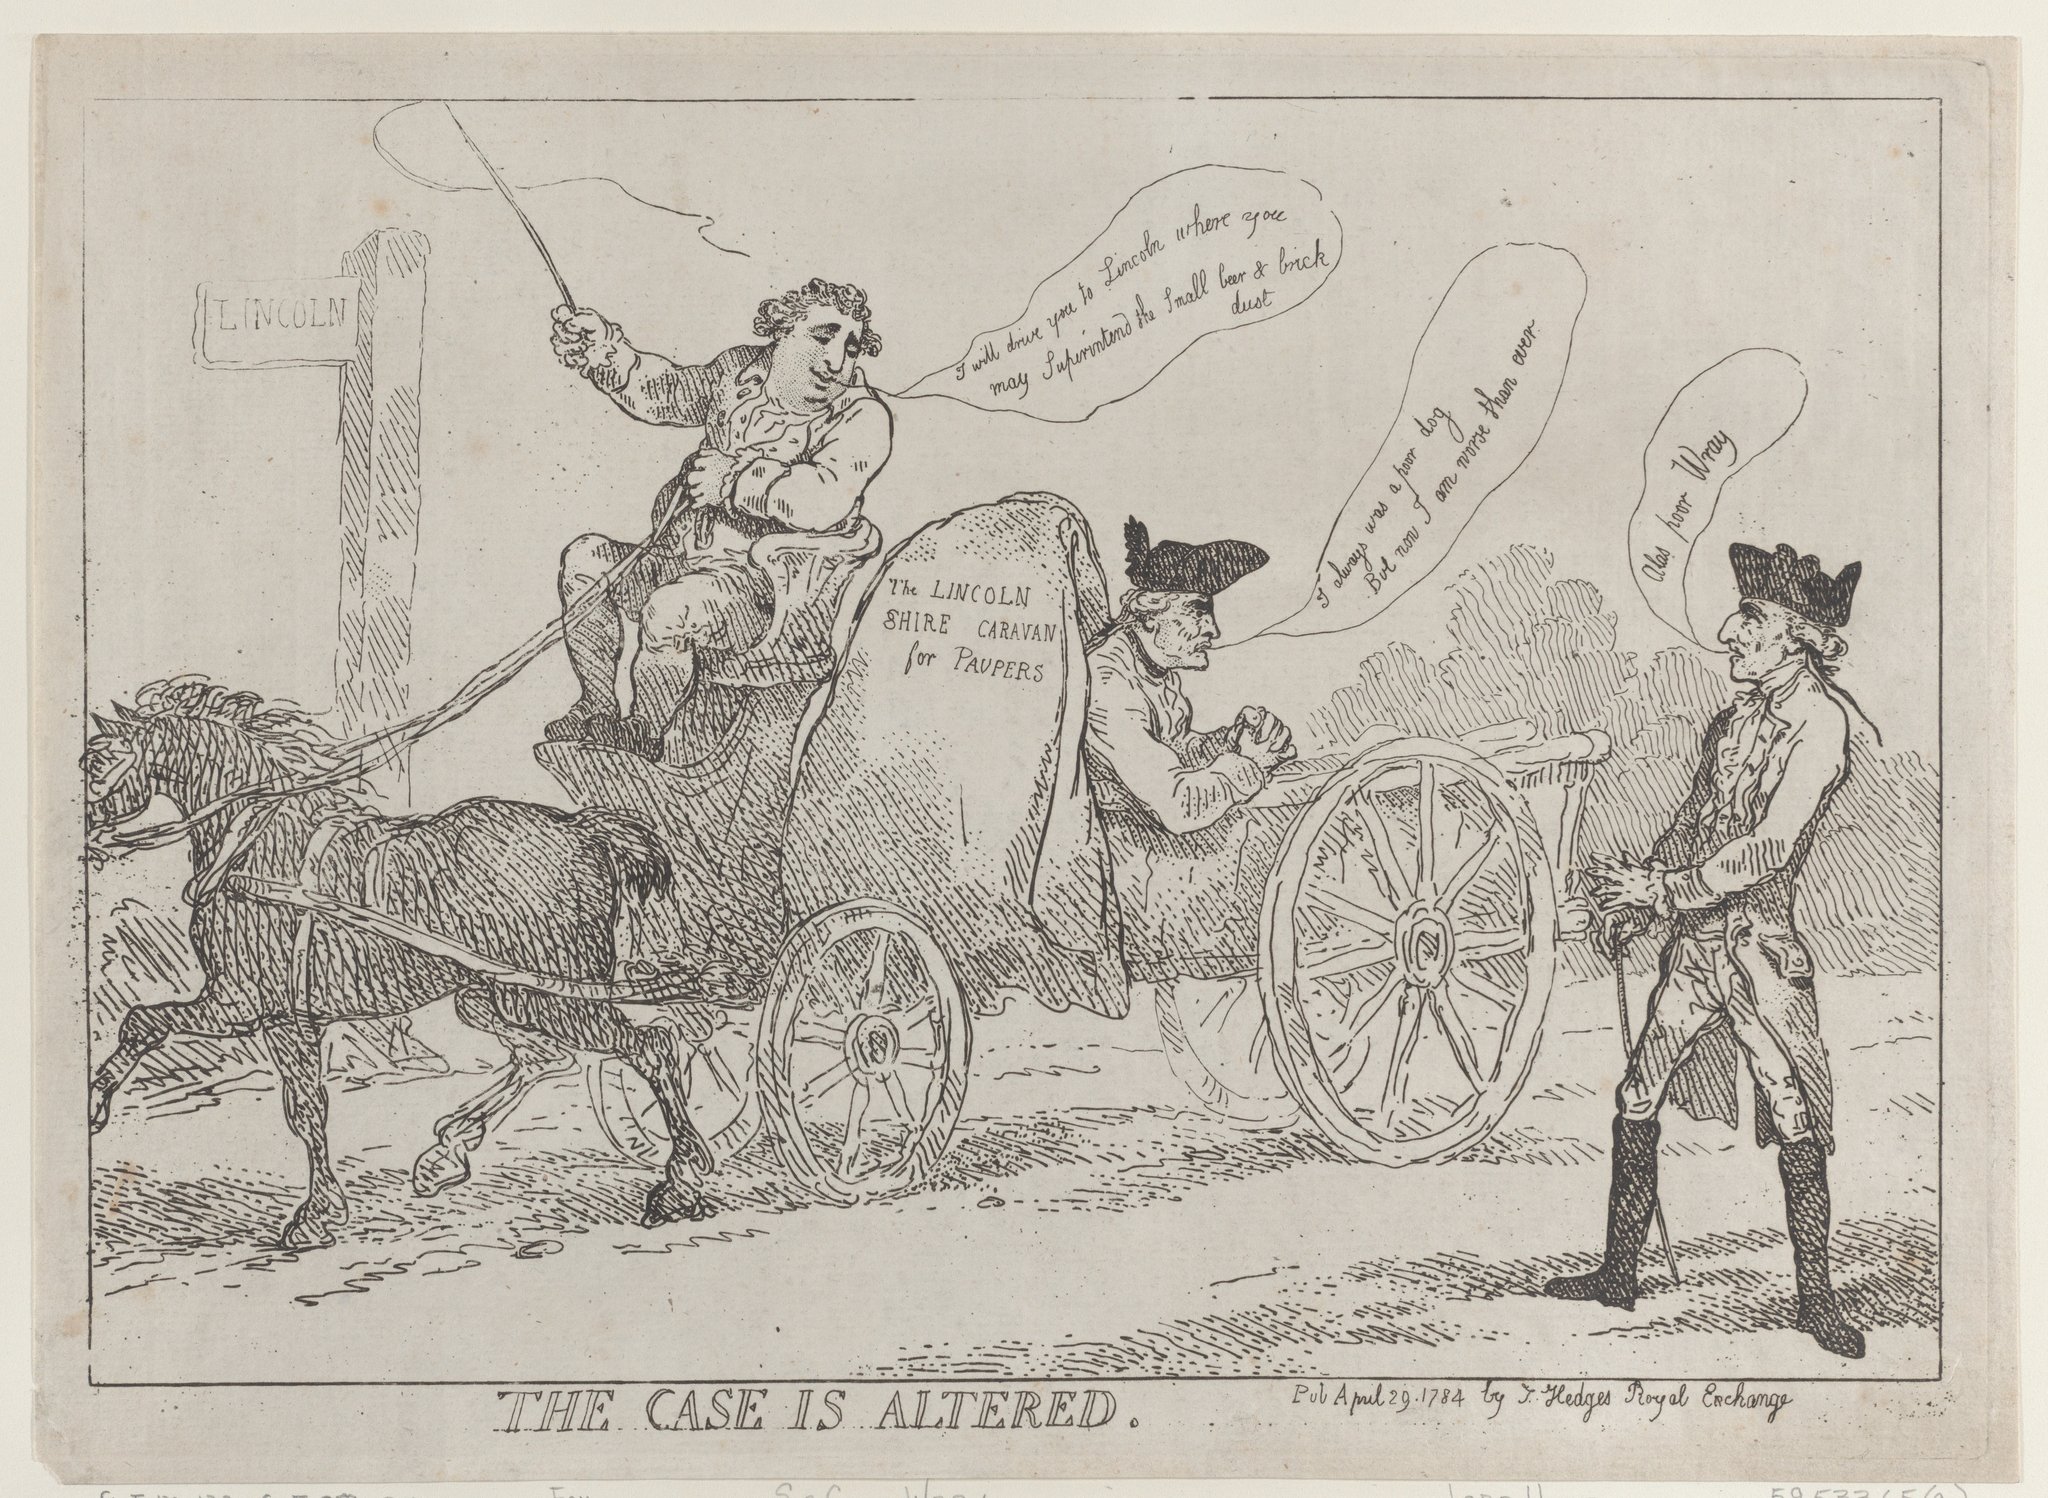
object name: print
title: The Case Is Altered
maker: thomas rowlandson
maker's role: artist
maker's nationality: british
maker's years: 1757-1827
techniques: etching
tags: satire,men,horses,carts